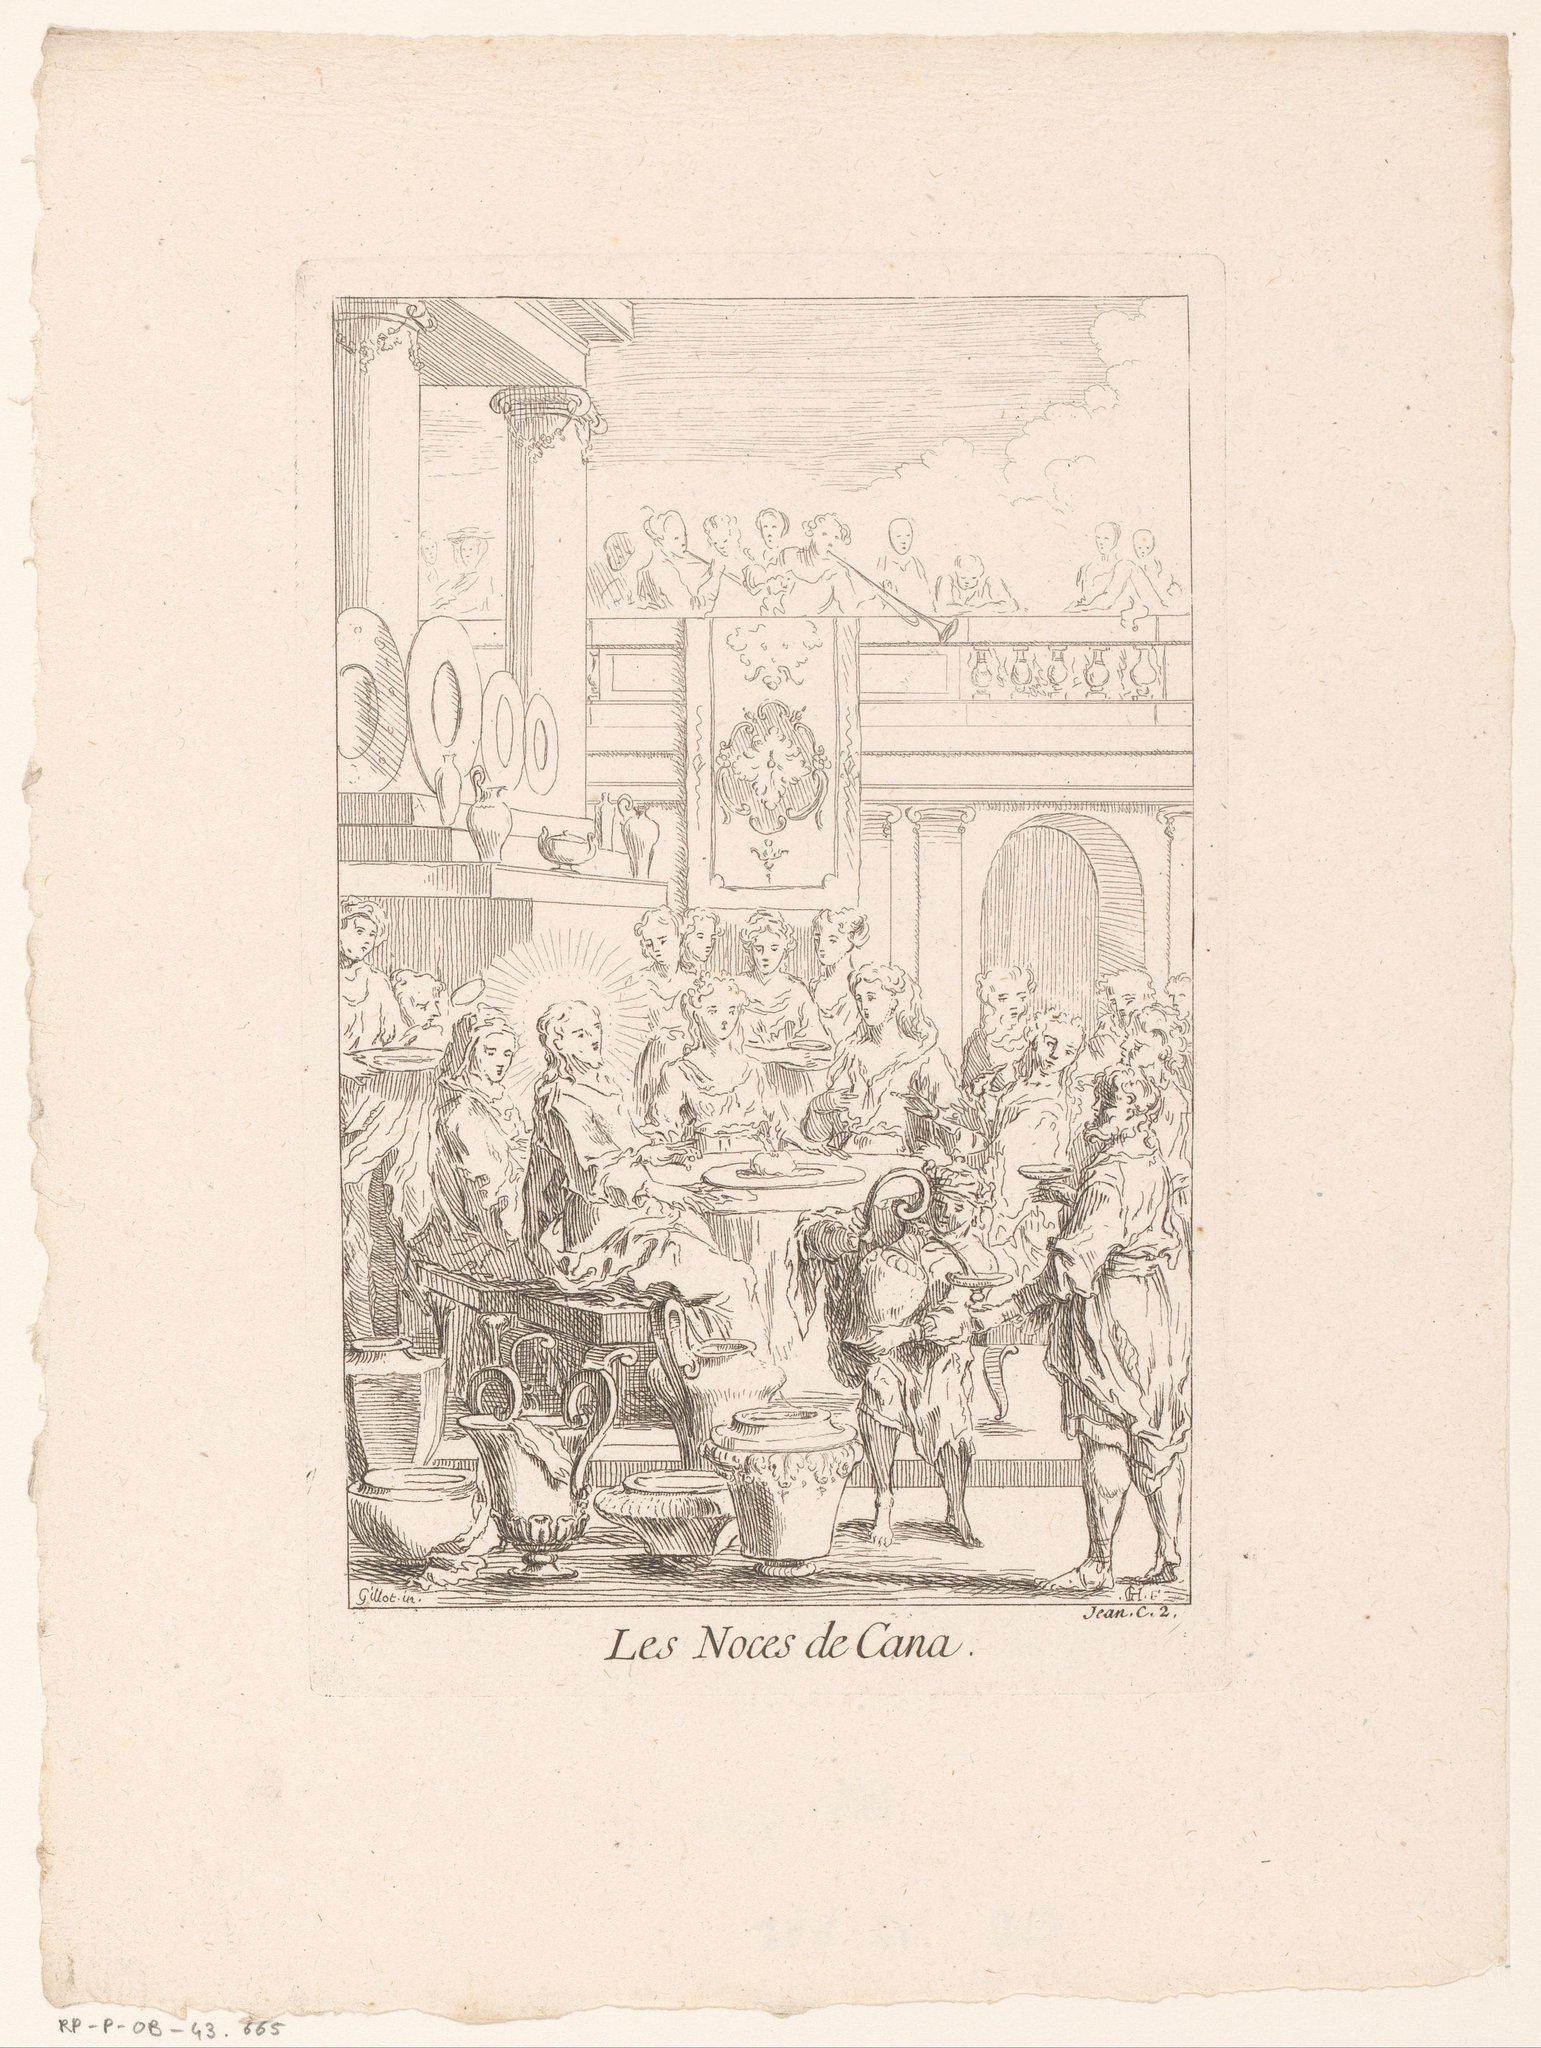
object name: print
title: Leven en passie van Christus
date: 1705-1732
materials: paper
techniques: etching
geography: paris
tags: christ orders (six) jars to be filled with water ~ marriage-feast at cana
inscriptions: collector's mark: Lugt 2228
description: Maakt deel uit van een serie met zestig prenten met als thema het leven van Christus.